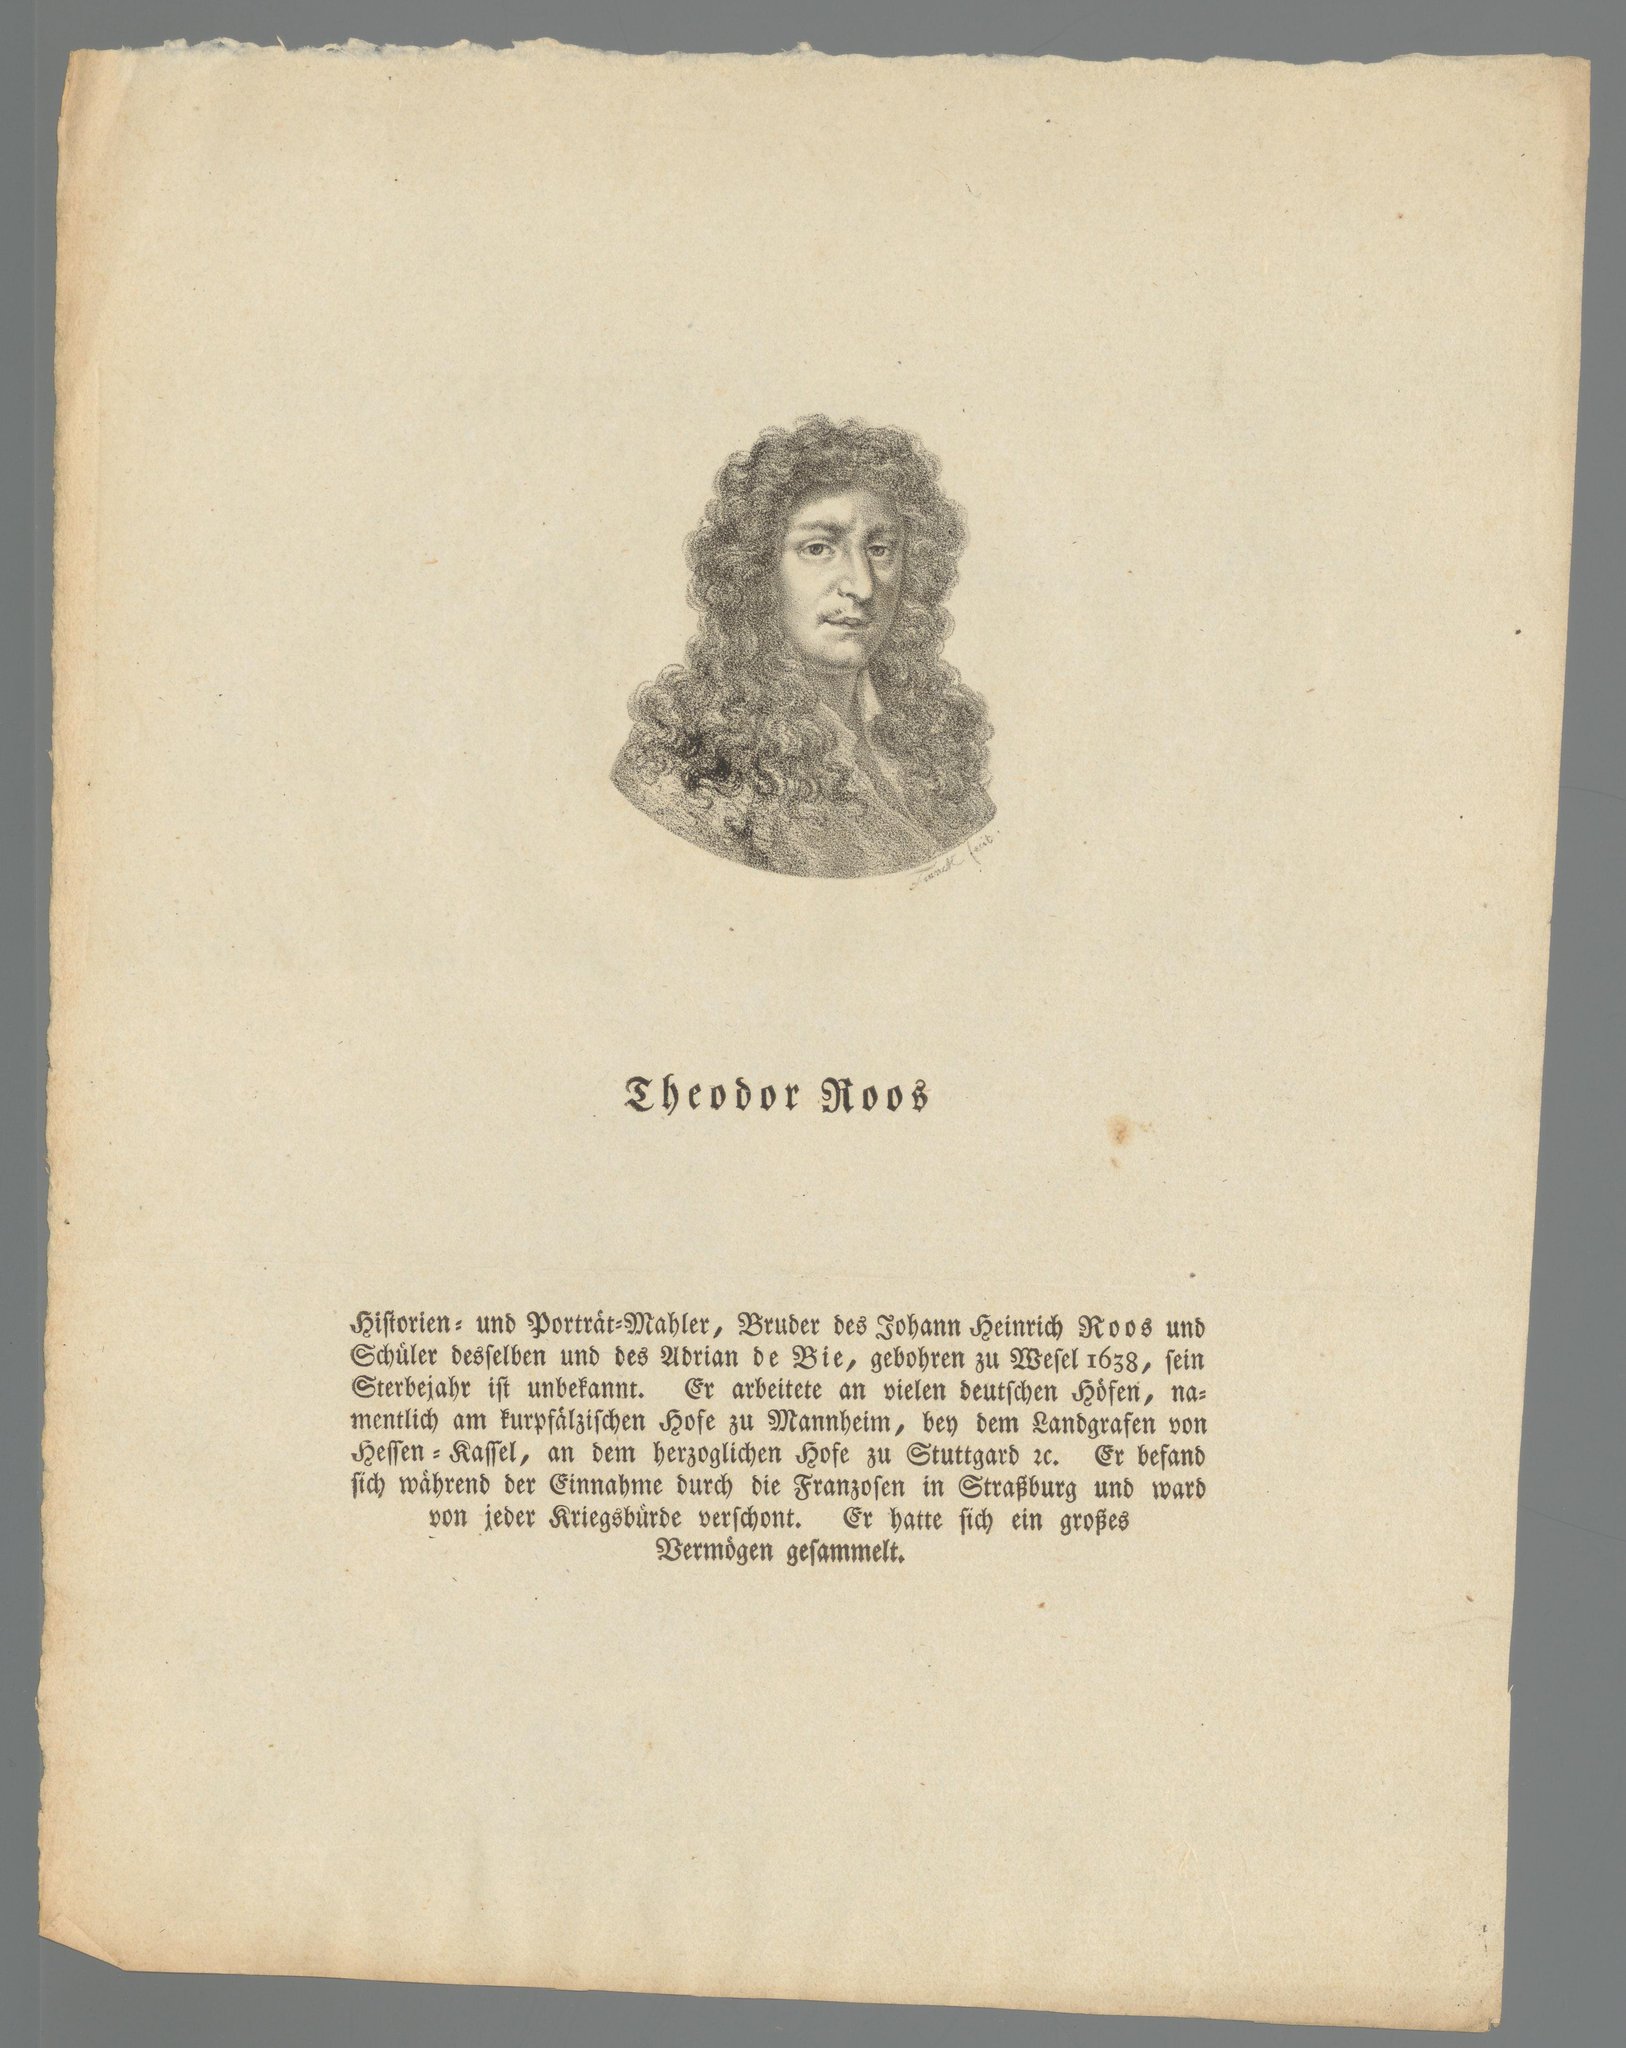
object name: print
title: Theodor Roos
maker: maximilian franck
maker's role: print maker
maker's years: 1780-1830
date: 1813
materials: paper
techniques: letterpress printing, lithograph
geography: munich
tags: painter, print maker, artist, theodor roos, historical persons, portrait, self-portrait of painter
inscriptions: collector's mark: Lugt 2228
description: Prent uit: Lindauer, Joseph. Deutsche Künstler-Gallerie. München: Maximilian Franck, 1813.